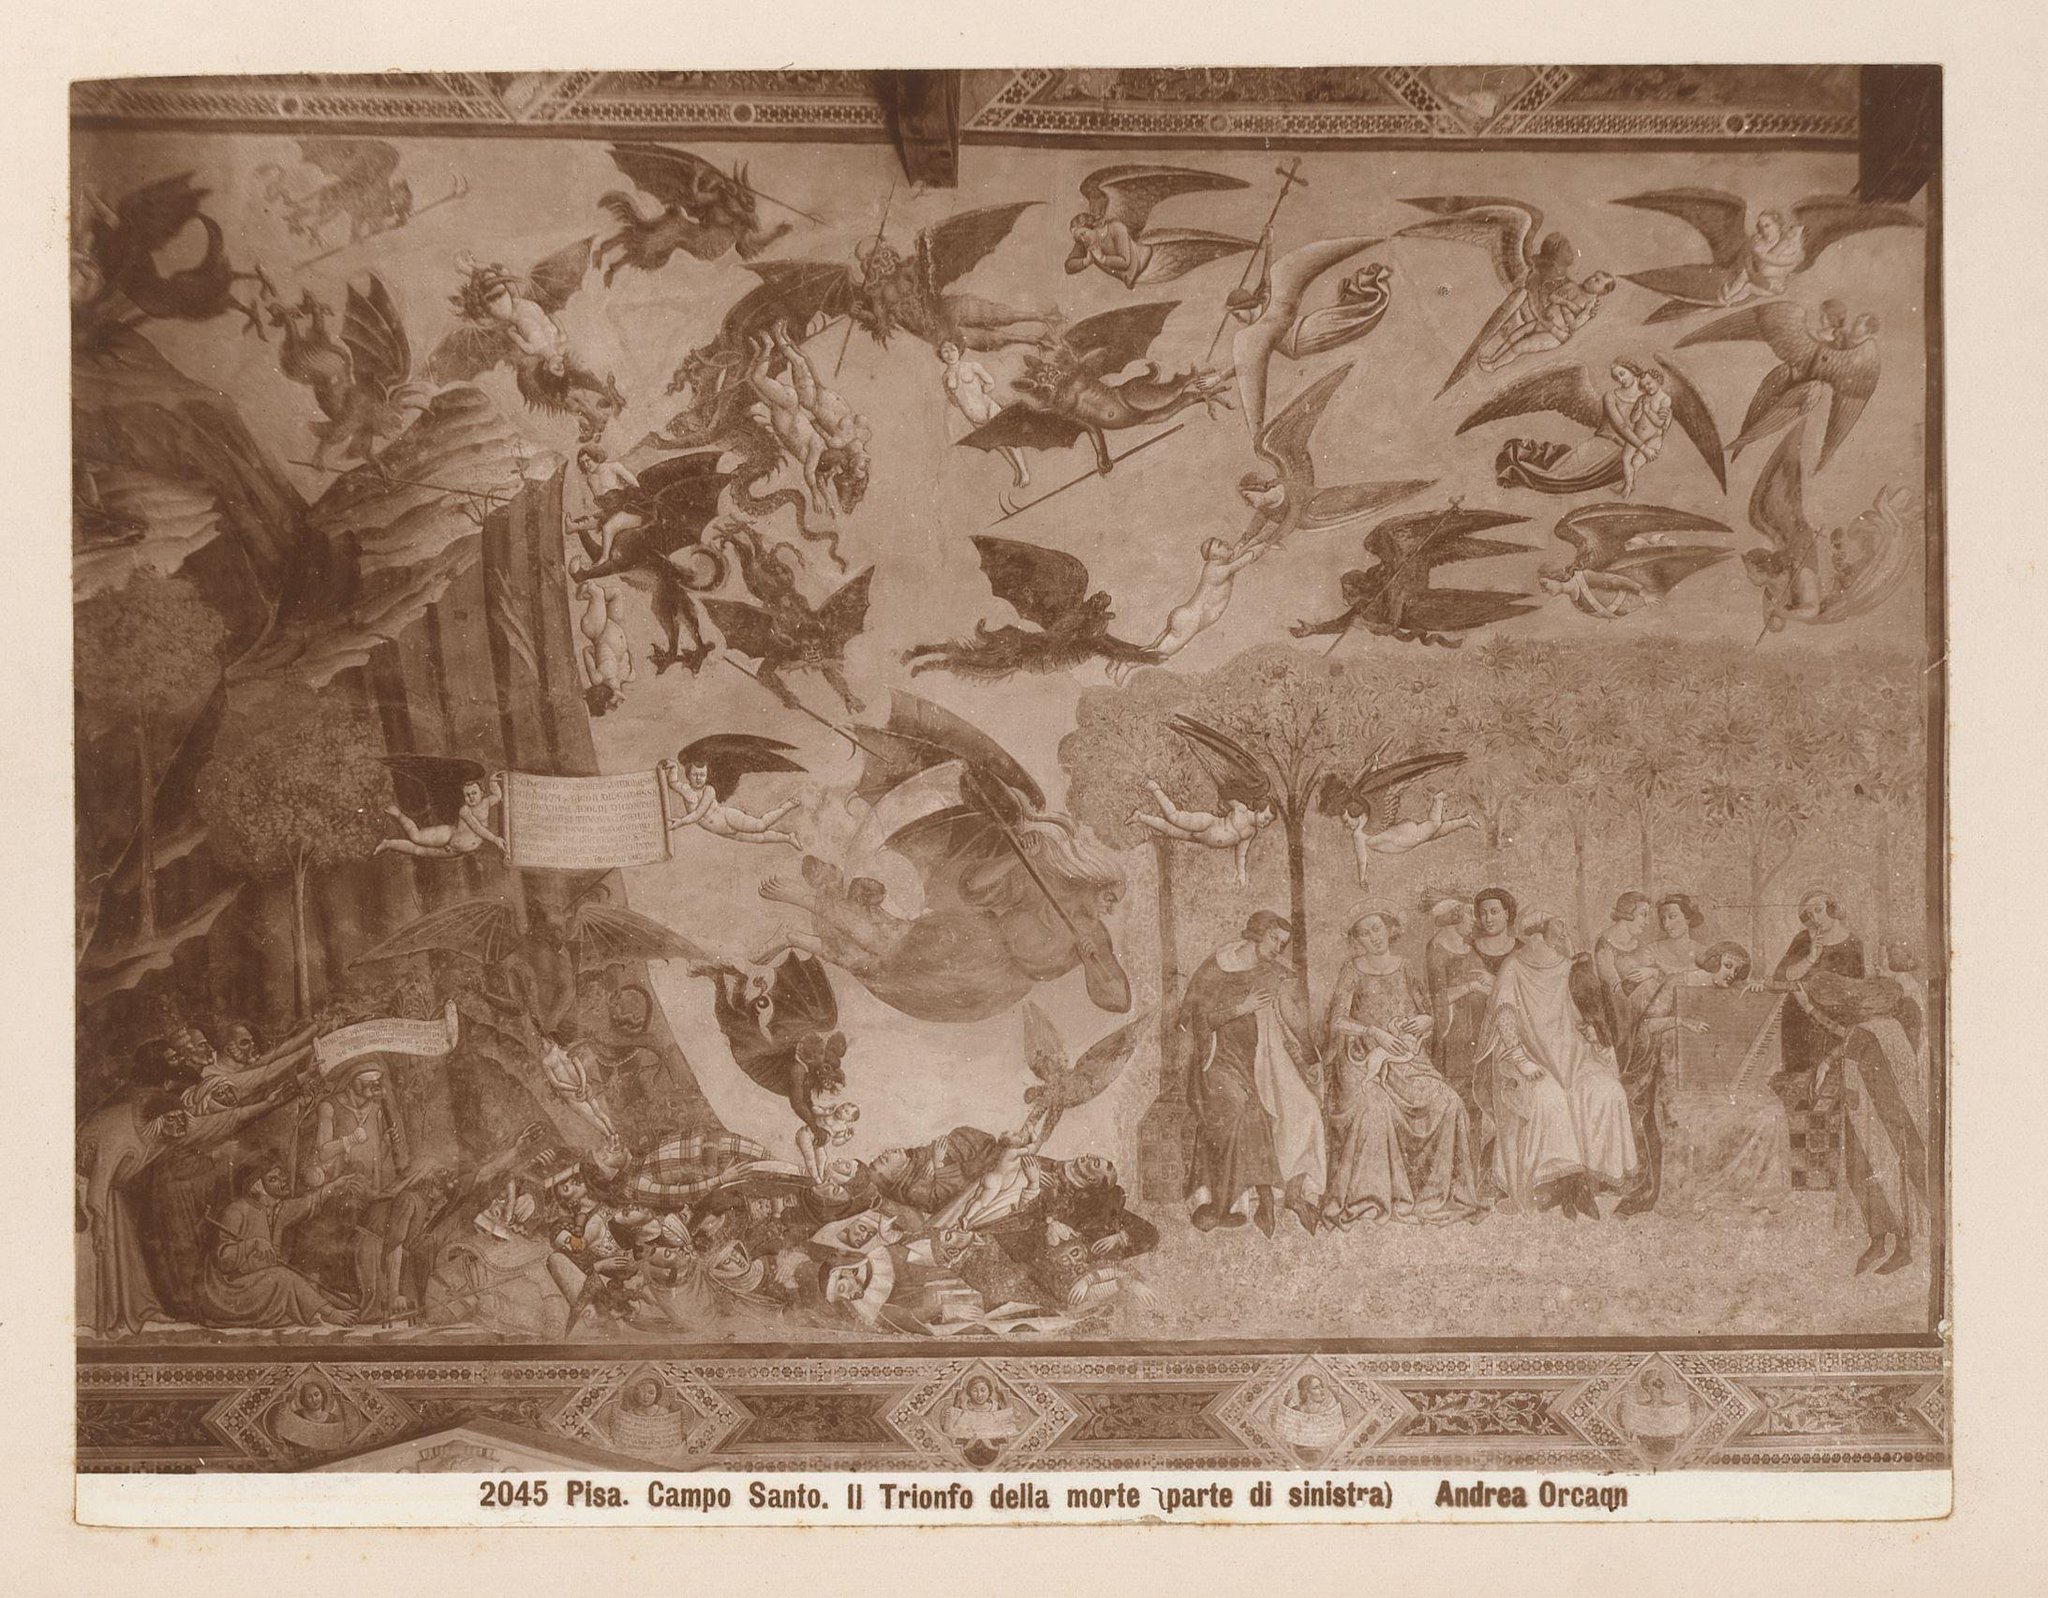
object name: reproduction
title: Fotoreproductie van het fresco De triomf der doden naar Andrea di Cione, genaamd Orcagna, in het Camposanto te Pisa, Italië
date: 1860-1881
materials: paper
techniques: albumen print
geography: pisa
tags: picture, painting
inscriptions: number: ‘2045’